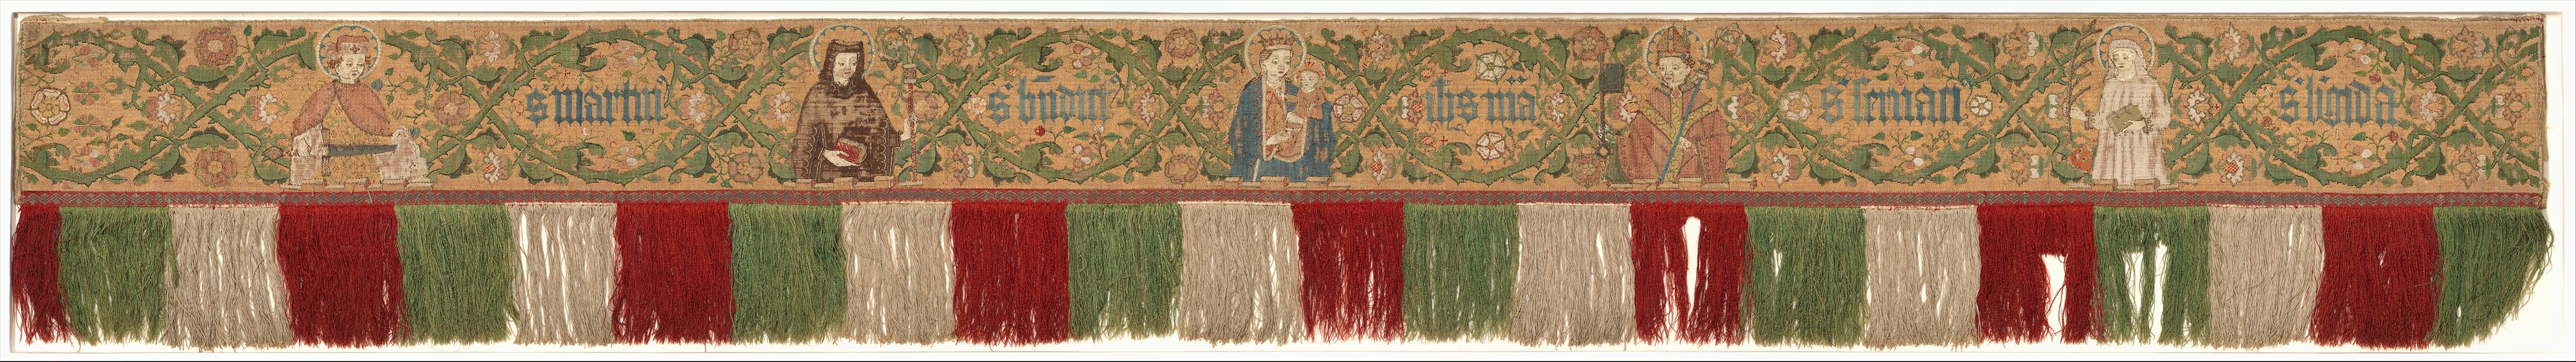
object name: praetexta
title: Praetexta of an Antependium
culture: german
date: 1450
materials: gold thread, linen, silk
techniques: embroidery, weave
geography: germany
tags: infants,women